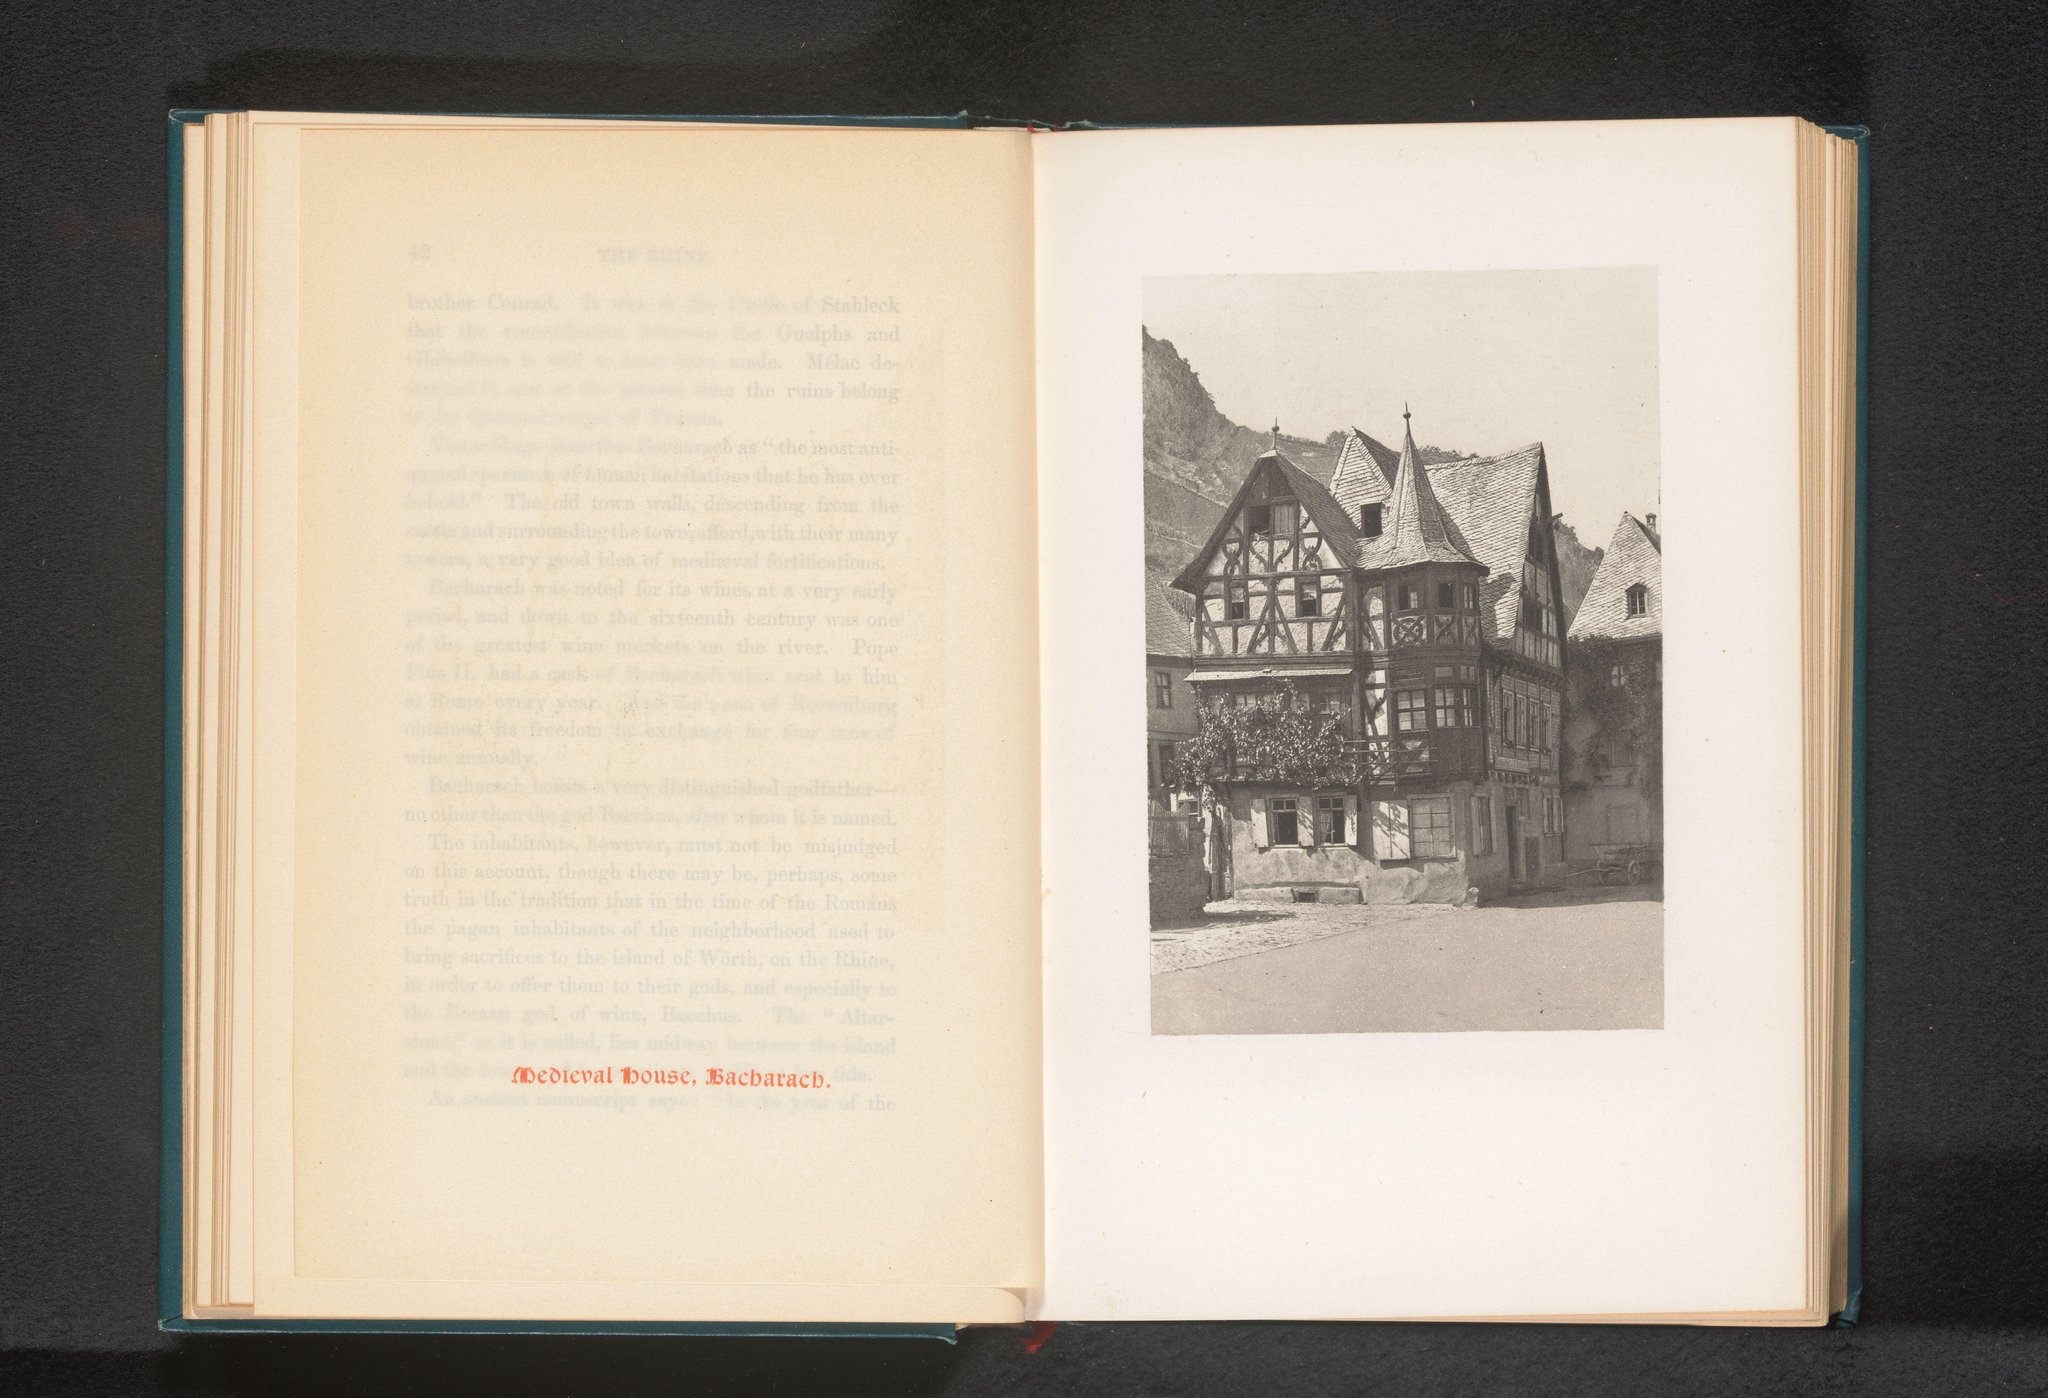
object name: page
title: Exterieur van een vakwerkhuis te Bacharach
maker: Anonymous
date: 1889-1899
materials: paper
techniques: photoaquatint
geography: bacharach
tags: timber framing, façade (of house or building)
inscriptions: title: ‘Medieval house, Bacharach.’